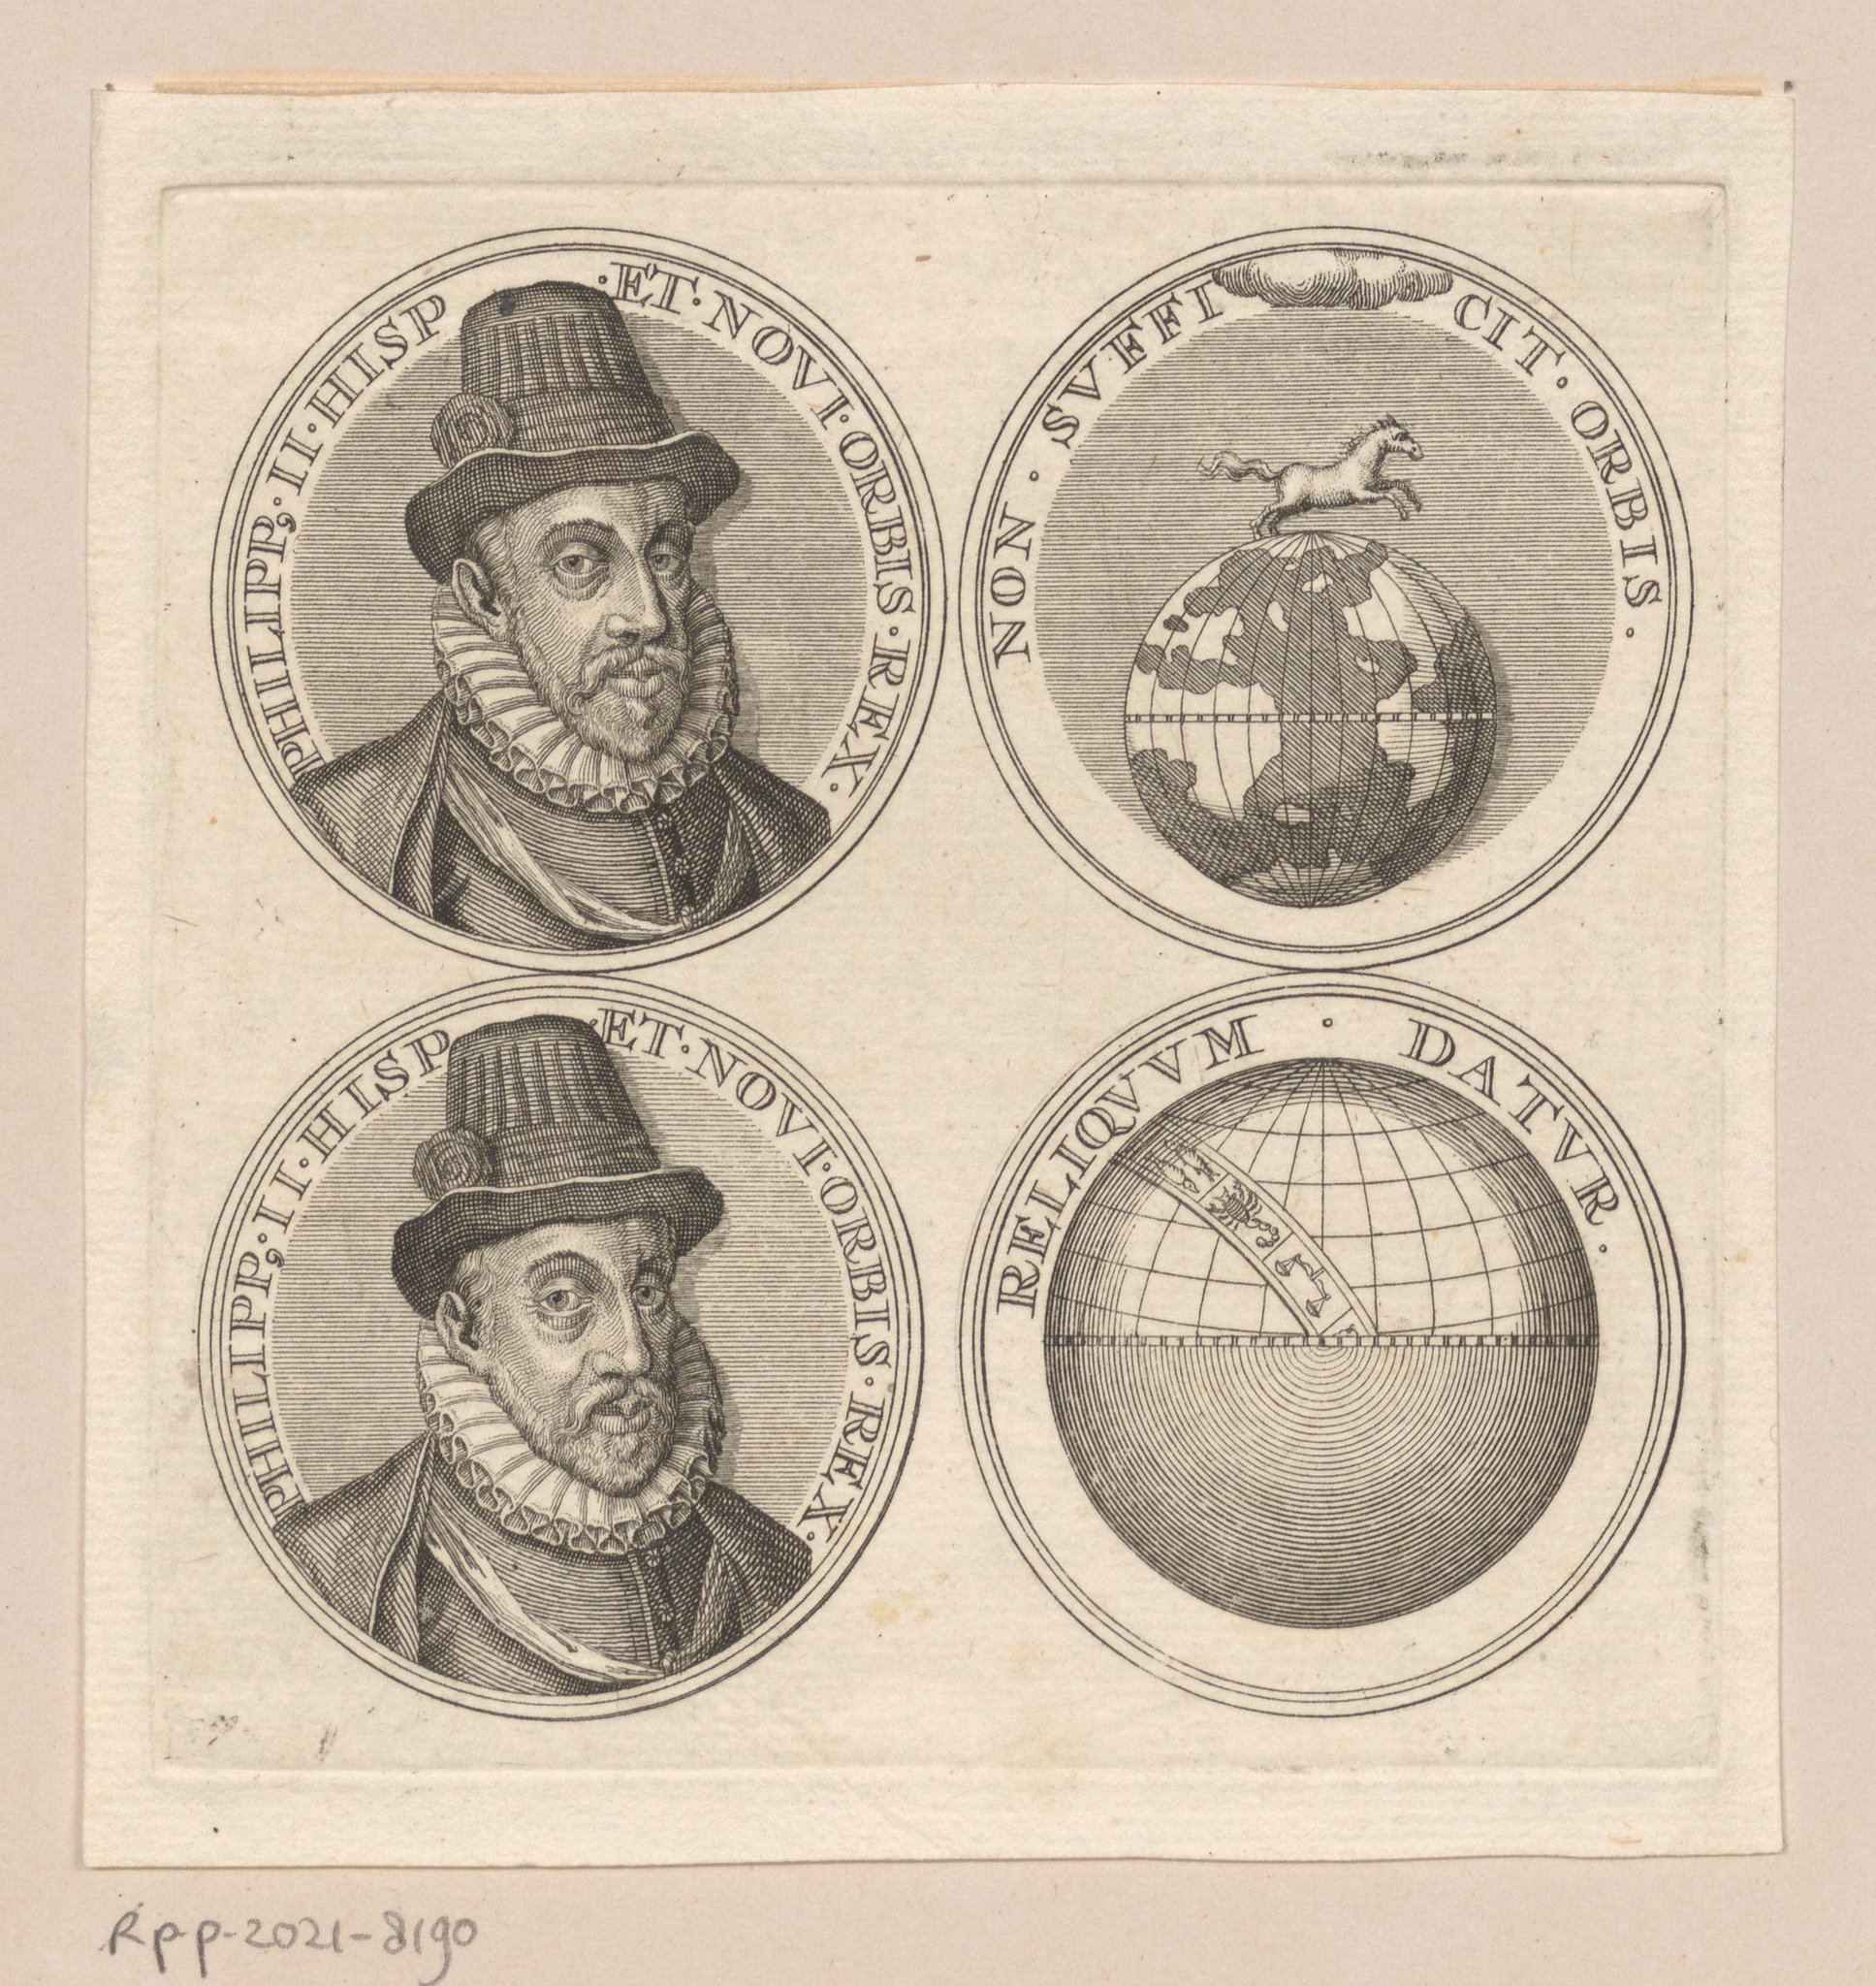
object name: print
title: Penningen met het portret van Filips II en een globe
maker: Anonymous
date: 1723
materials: paper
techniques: engraving, etching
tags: philip ii of spain, historical persons, coin, globe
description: Prent met tekst op verso gebruikt in: Loon, Gerard van. Beschryving der Nederlandsche Historipenningen (...). Den Haag: Christiaan van Lom, Isaac Vaillant, Pieter Gosse, Rutger Alberts en Pieter de Hondt, 1723, dl. 1.